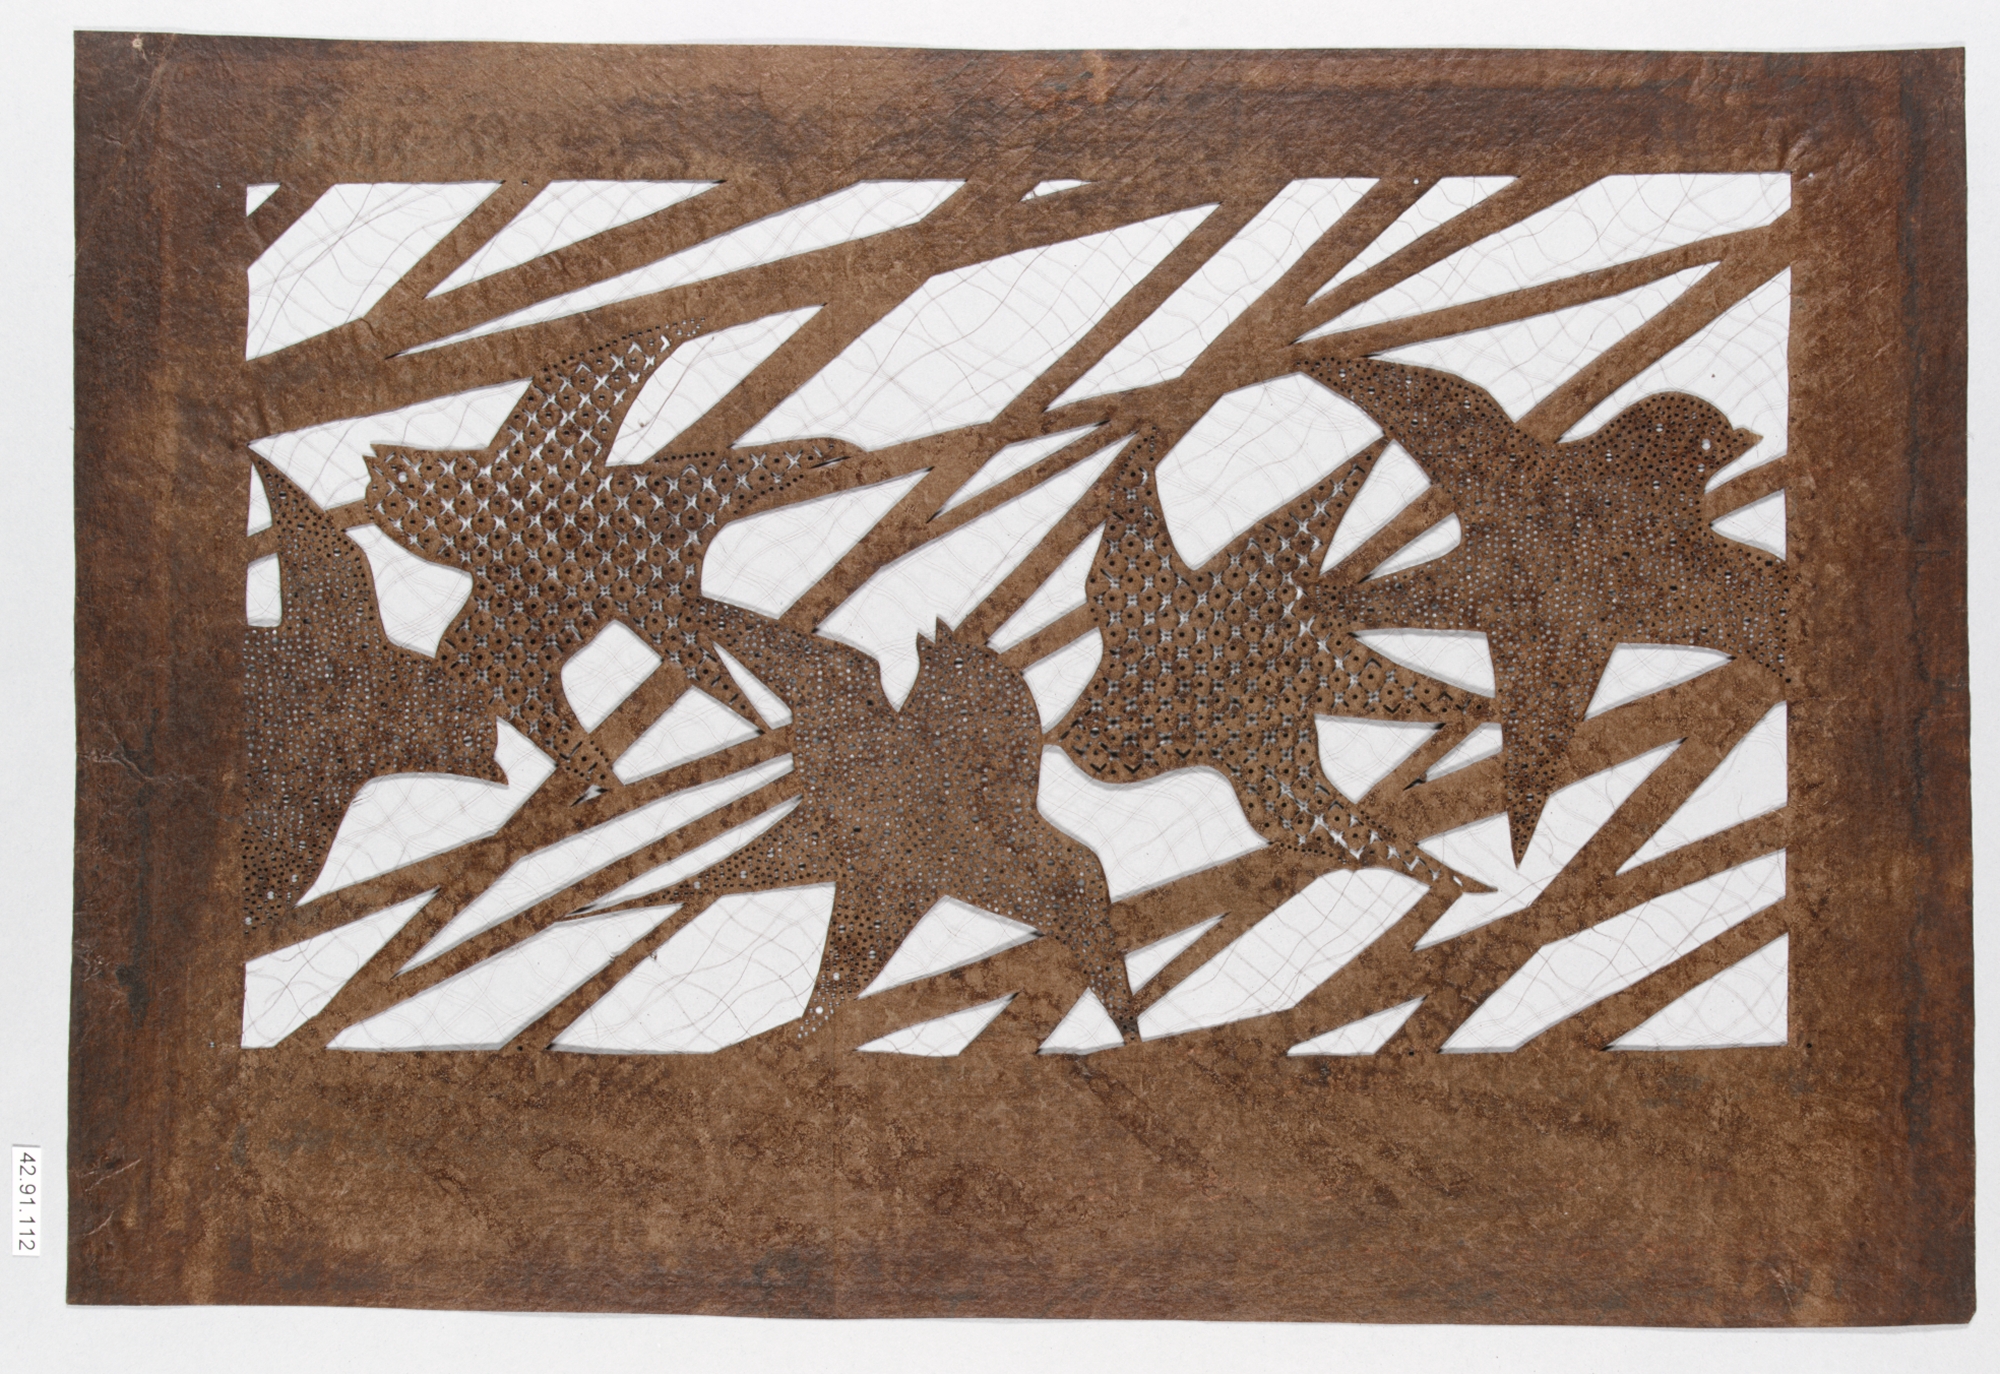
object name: stencil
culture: japanese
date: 1801-1900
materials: paper, silk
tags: birds